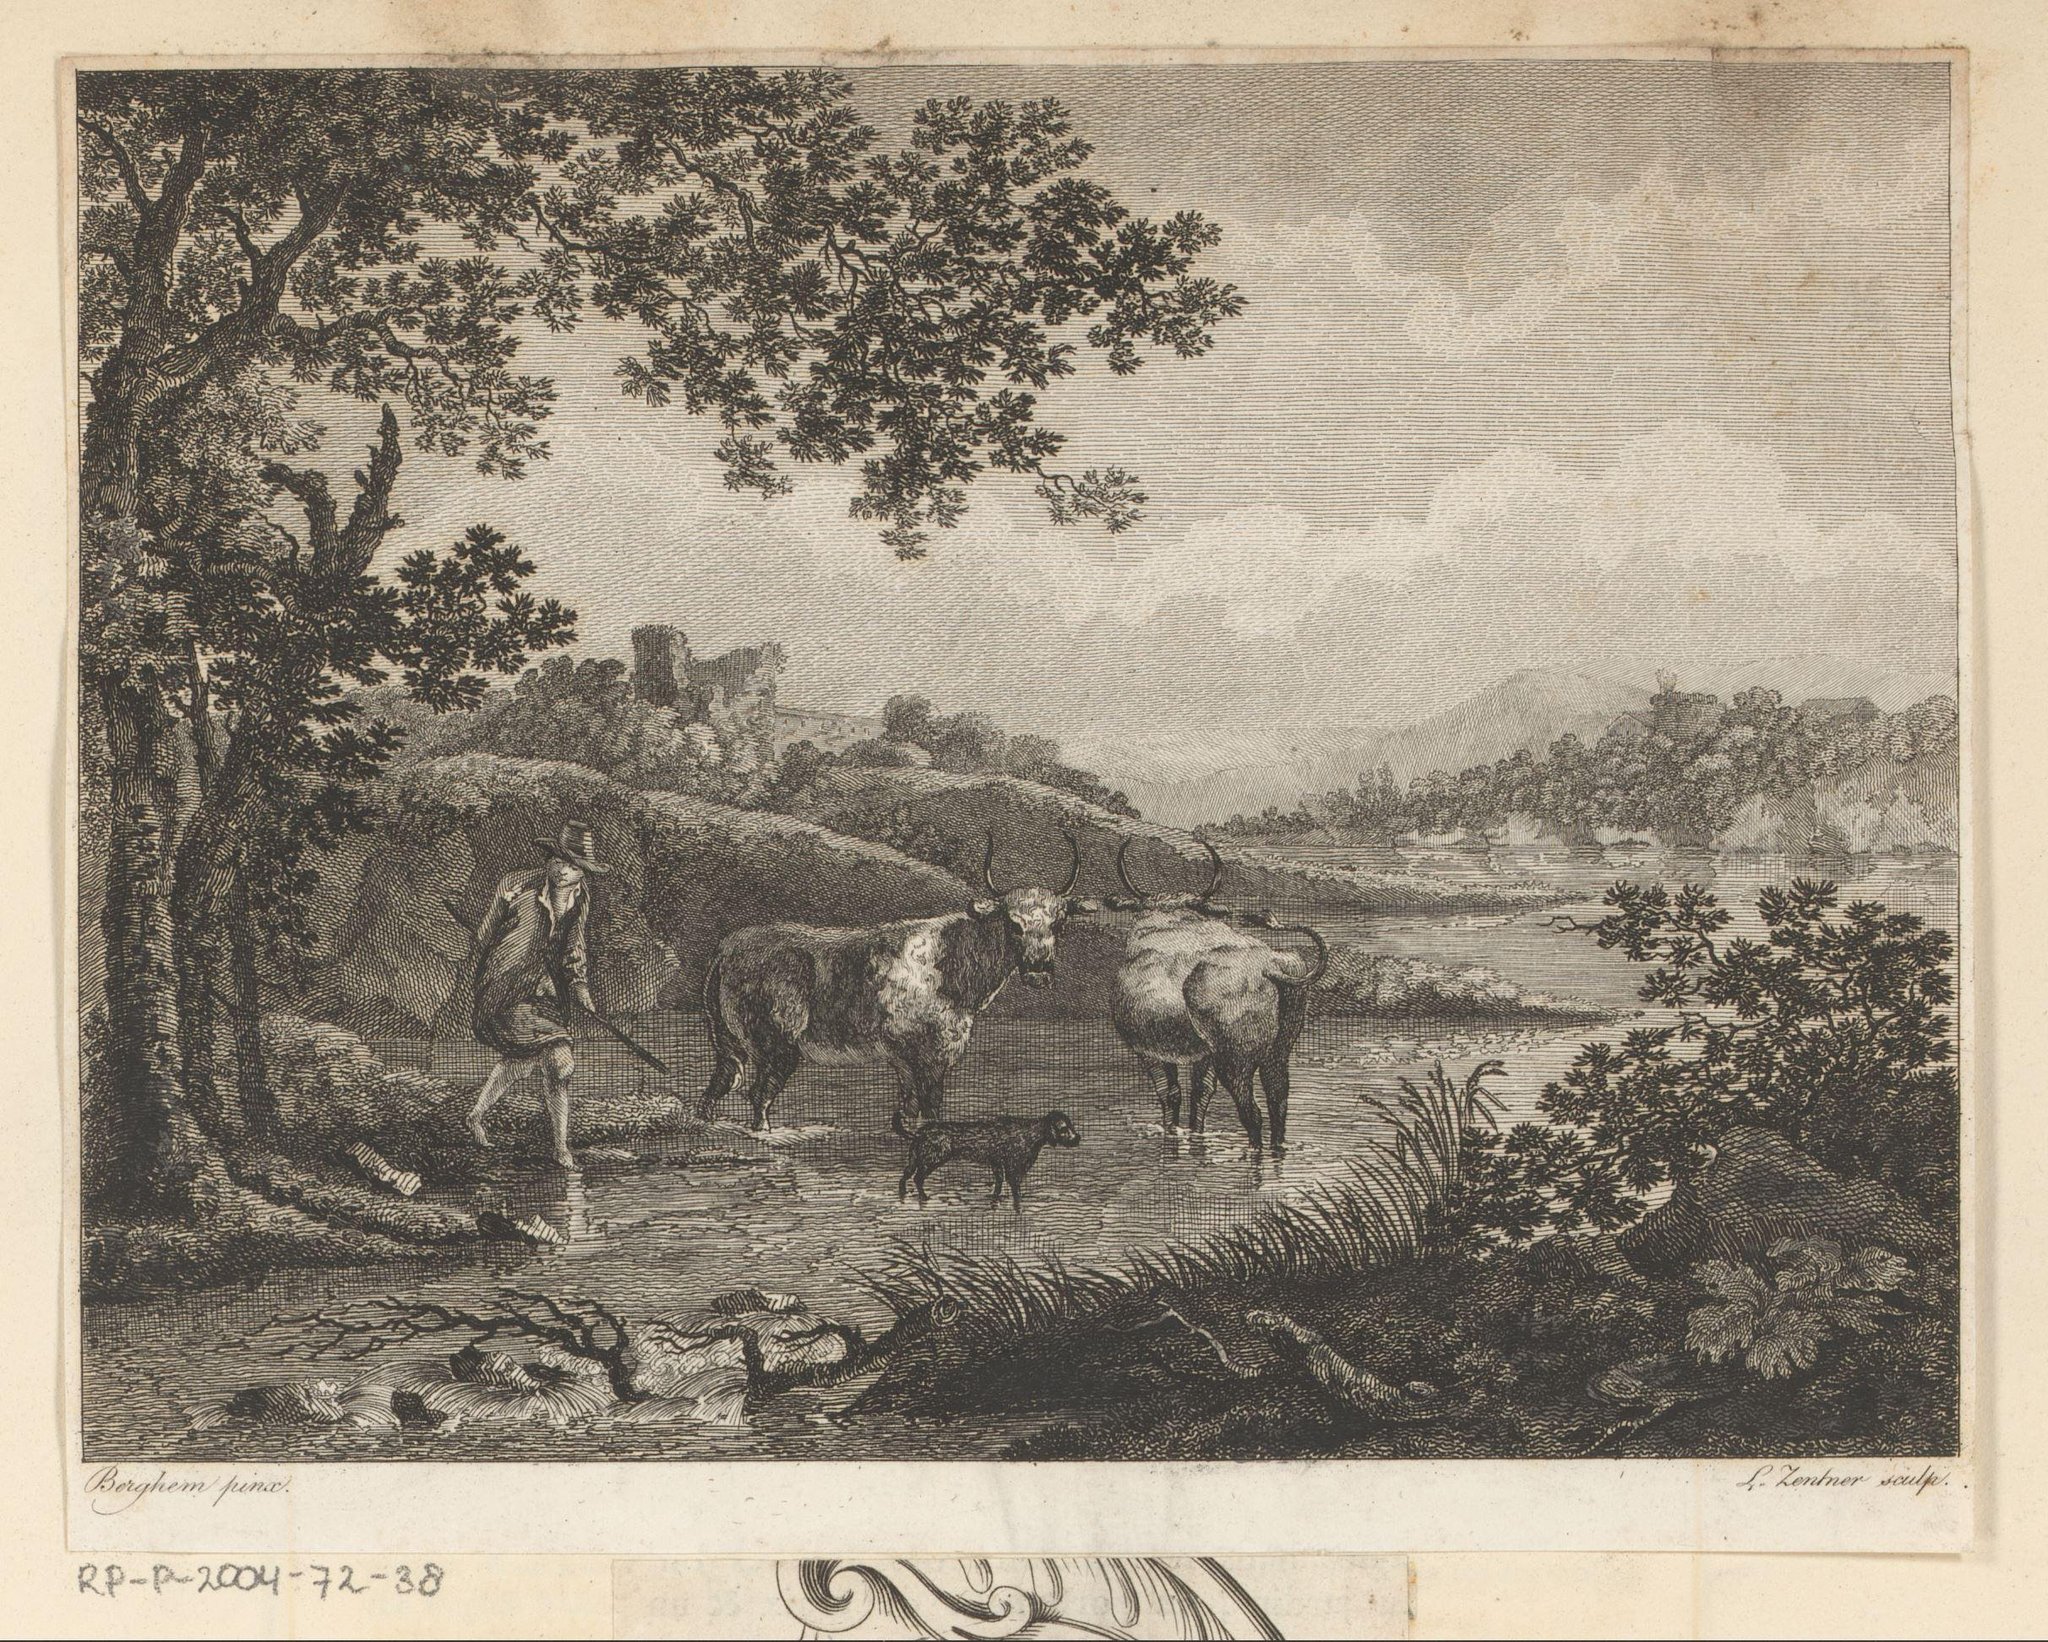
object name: album leaf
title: Herder aan de oever van een rivier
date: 1791-1798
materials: paper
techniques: engraving, etching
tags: herding, herdsman, herdswoman, shepherd, shepherdess, cowherd, etc., river bank (+ landscape with figures, staffage)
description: Prent uit: Zentner, J.L.L.C.. A select Collection of landscapes, from the best old masters, one of each engraved by L. Zentner, after drawings made by him from original pictures (...). Londen: J. Thane, [1791-1798]. De samensteller heeft deze prent in het album geplakt als illustratie bij: Pilkington, Matthew en Johann Heinrich Füssli. A dictionary of painters, from the revival of the art to the present period. 4 dln. Londen: John Crowder, 1805, dl. 1, p. 42.